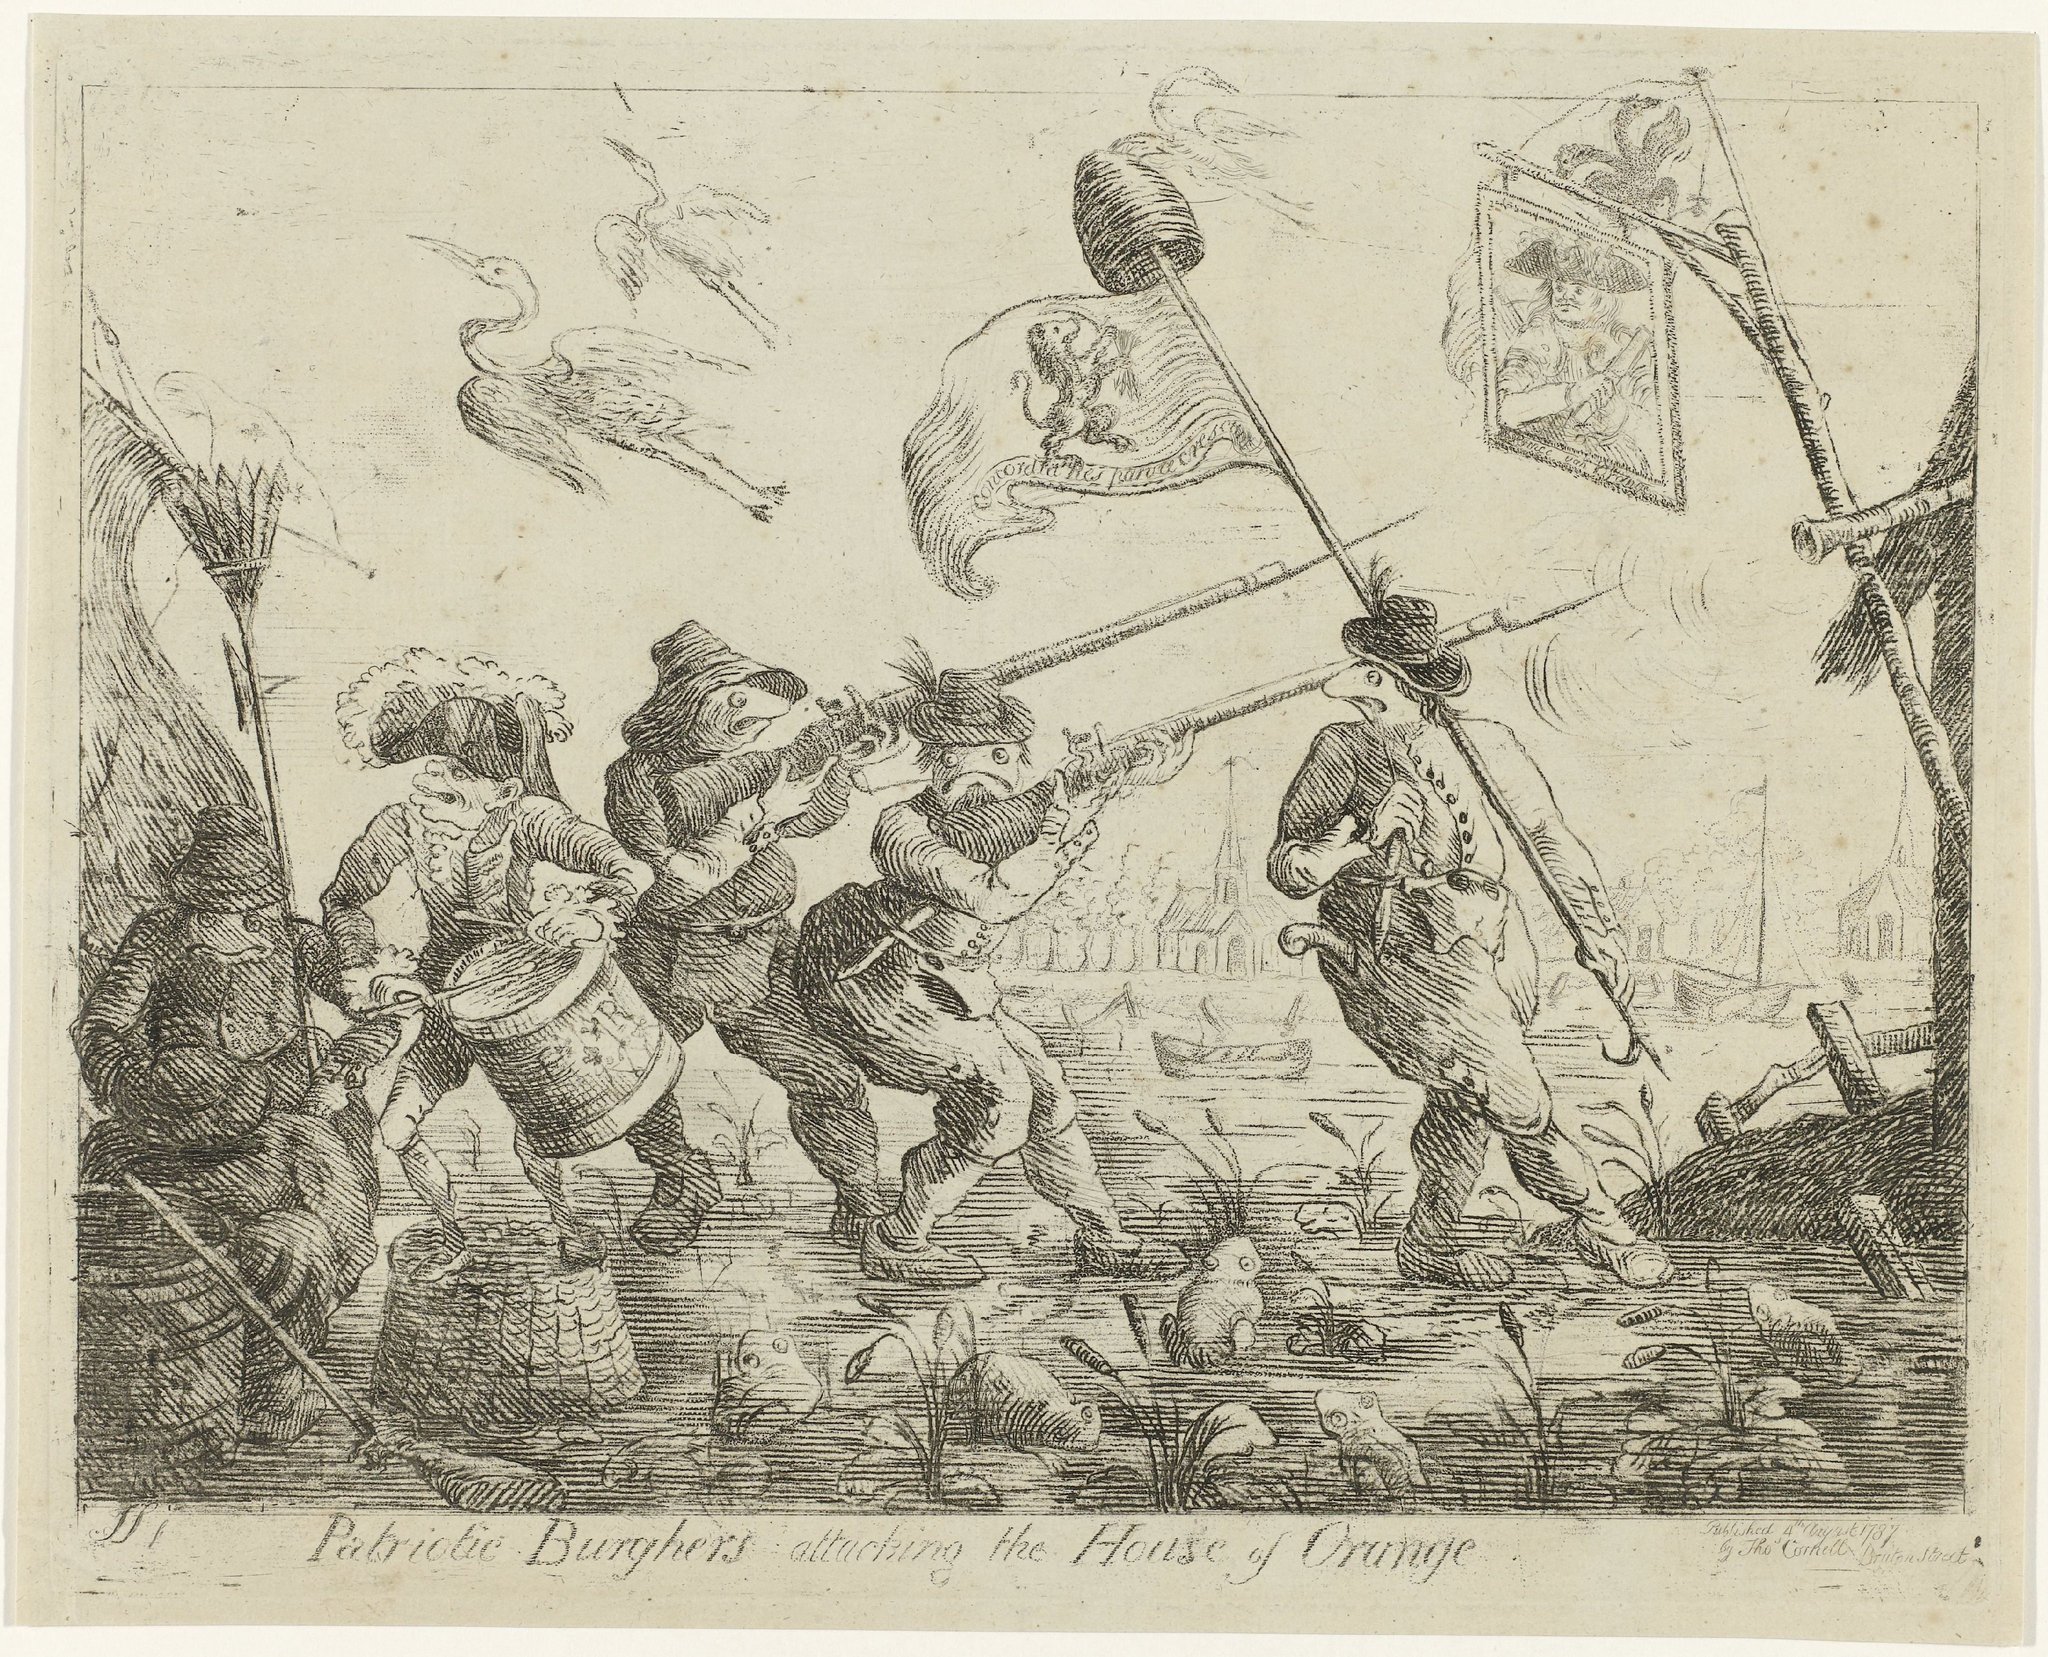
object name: print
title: Spotprent op Goejanverwellesluis, 1787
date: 1787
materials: paper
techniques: etching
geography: london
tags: berlin, draughtsman, wilhelmina of prussia (princess of orange), tailless amphibians: frog, animals acting as human beings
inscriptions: collector's mark: Lugt 2228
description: Spotprent op de aanhouding van prinses Wilhelmina van Pruisen te Goejanverwellesluis door patriotten, 28 juni 1787. Een groep van kikkers verkleed als patriotse soldaten voeren, hiertoe aangespoord door een Franse trommelaar, een aanval uit op een hut met een aanhangbord met de Prins van Oranje en een vaandel met de dubbele adelaar van Pruisen.